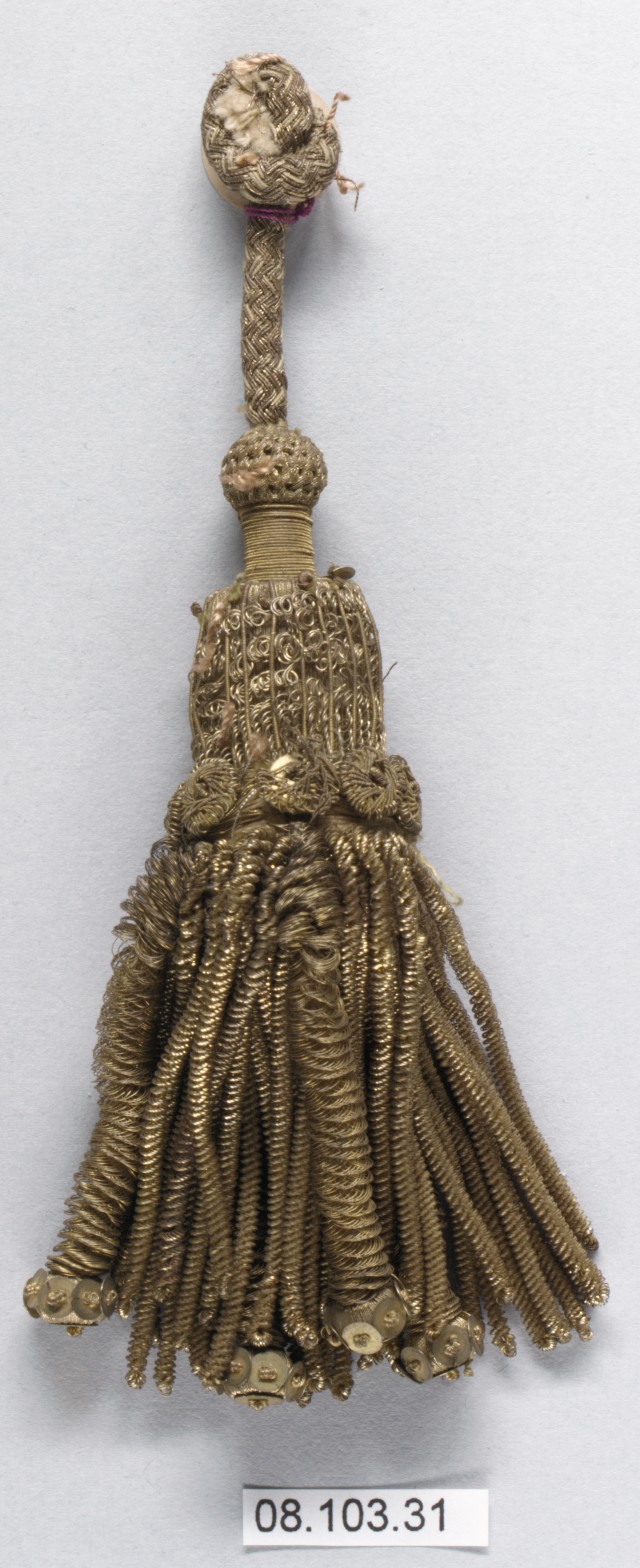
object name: tassel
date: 1801-1833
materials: metal thread